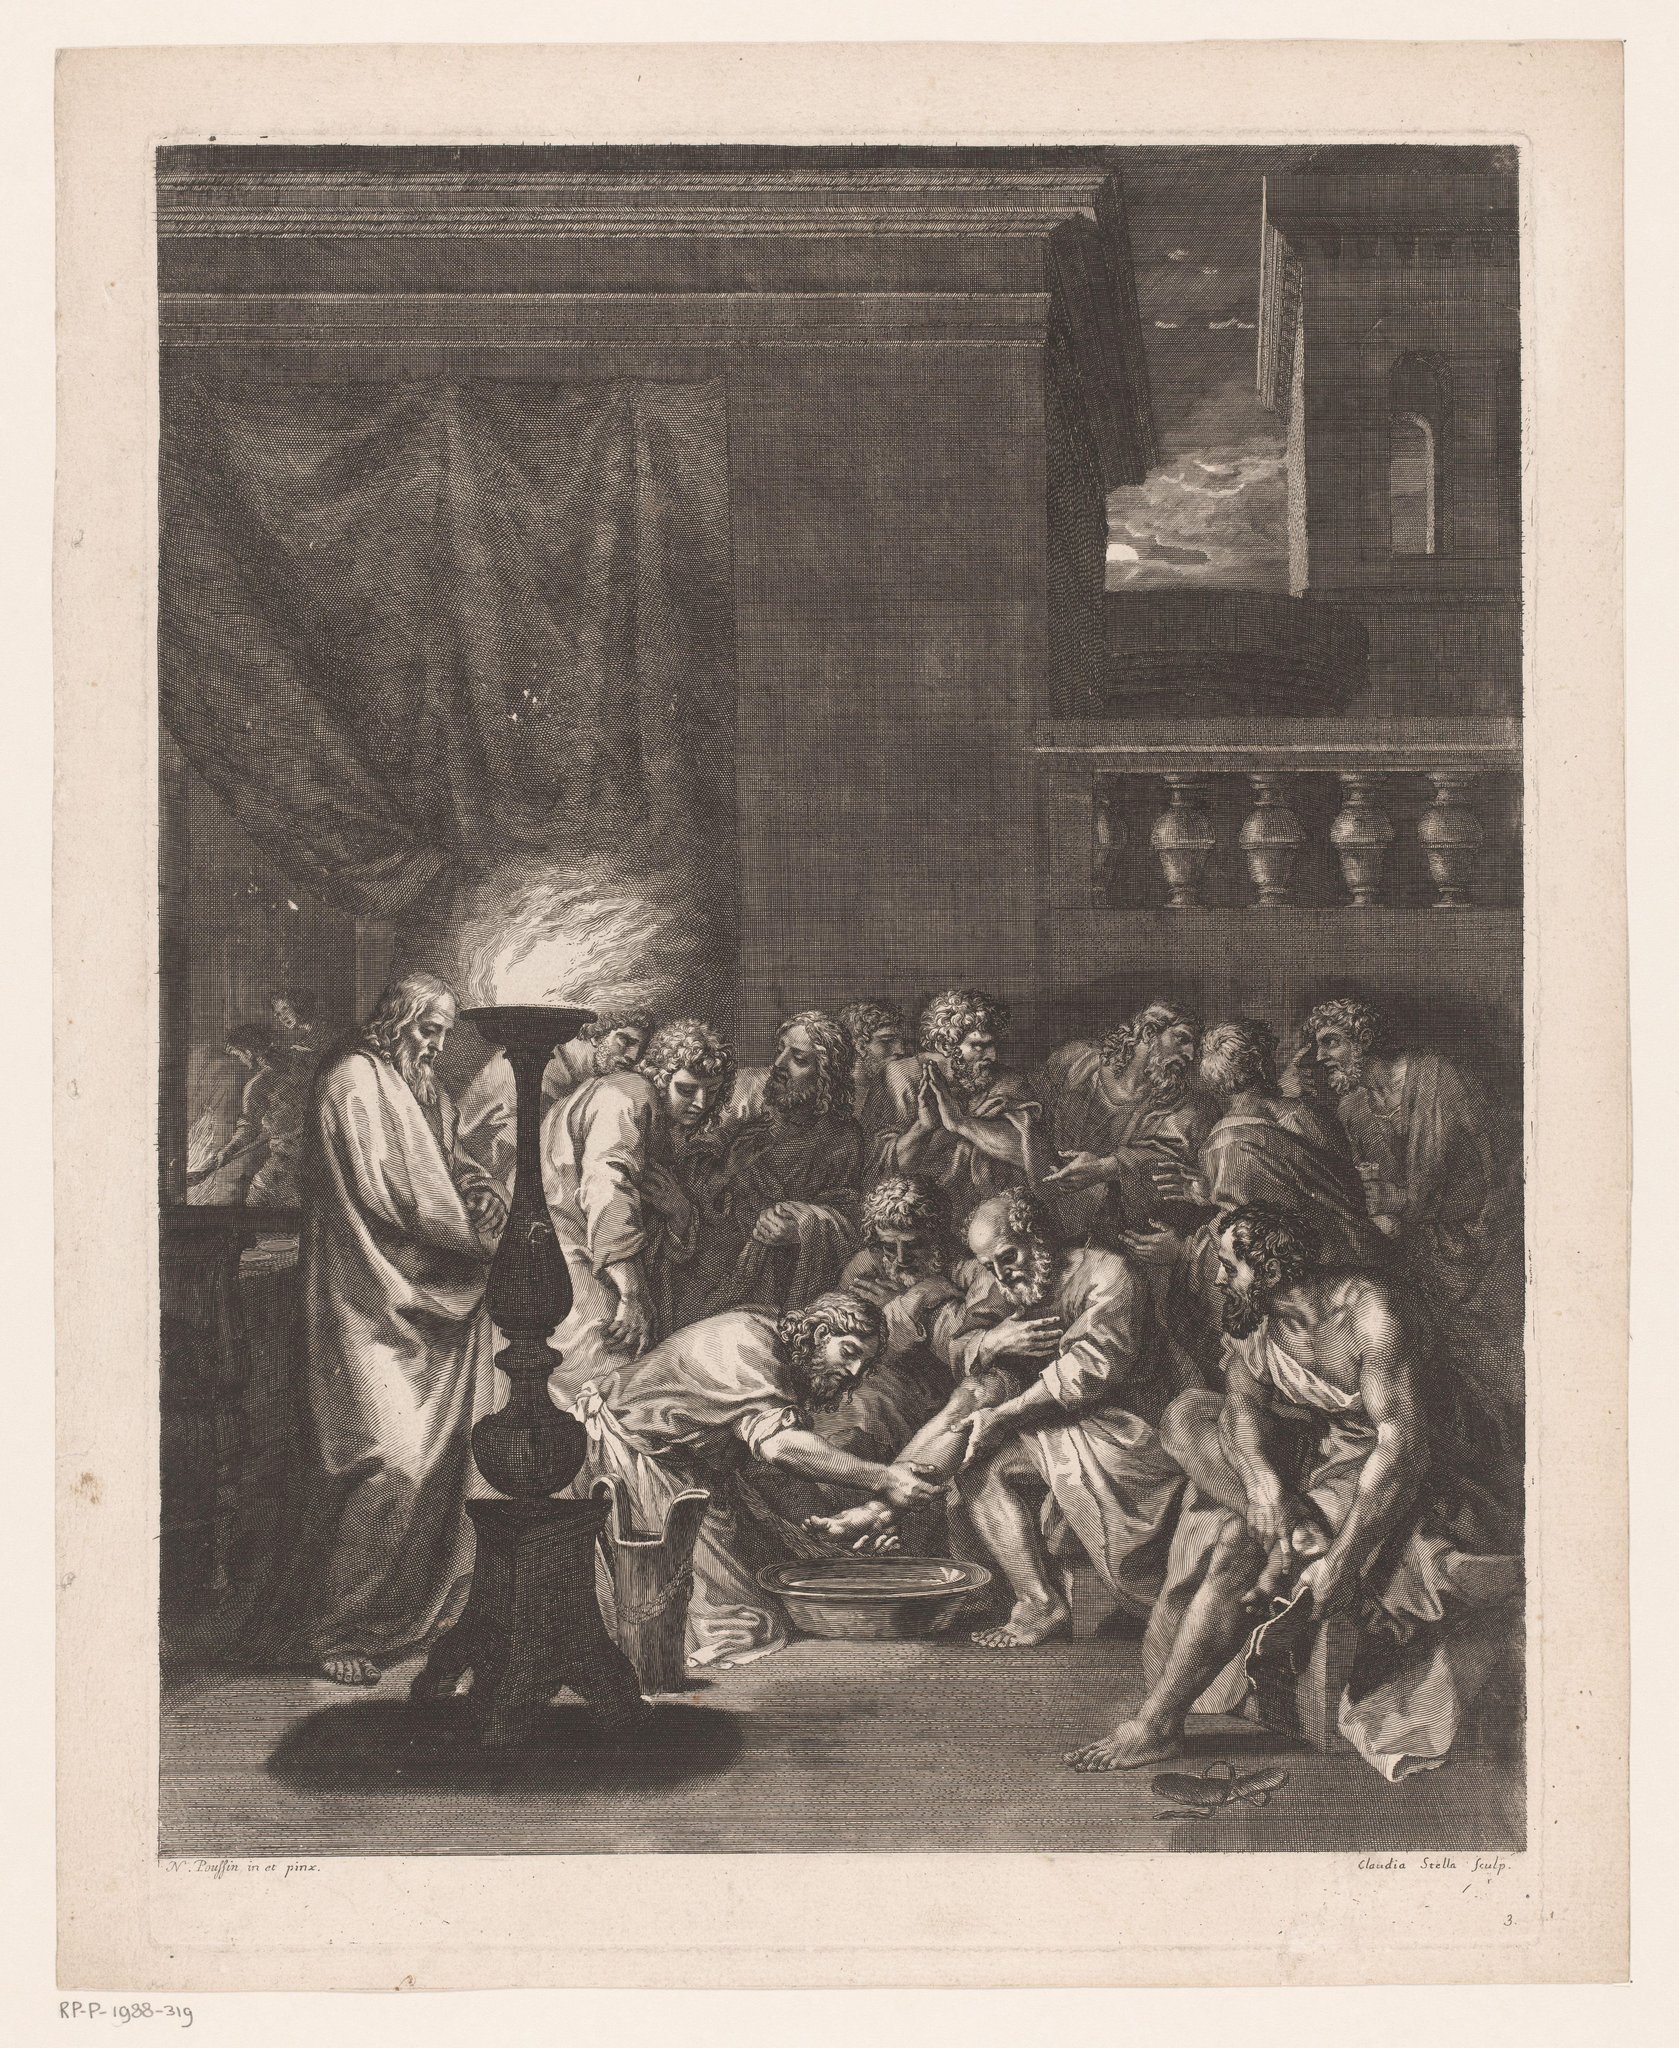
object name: print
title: Het leven en lijden van Christus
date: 1646-1697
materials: paper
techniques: engraving, etching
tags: christ washes the feet of the apostles (john 13:1-20)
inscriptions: collector's mark: Lugt 2228, collector's mark: Lugt 2760